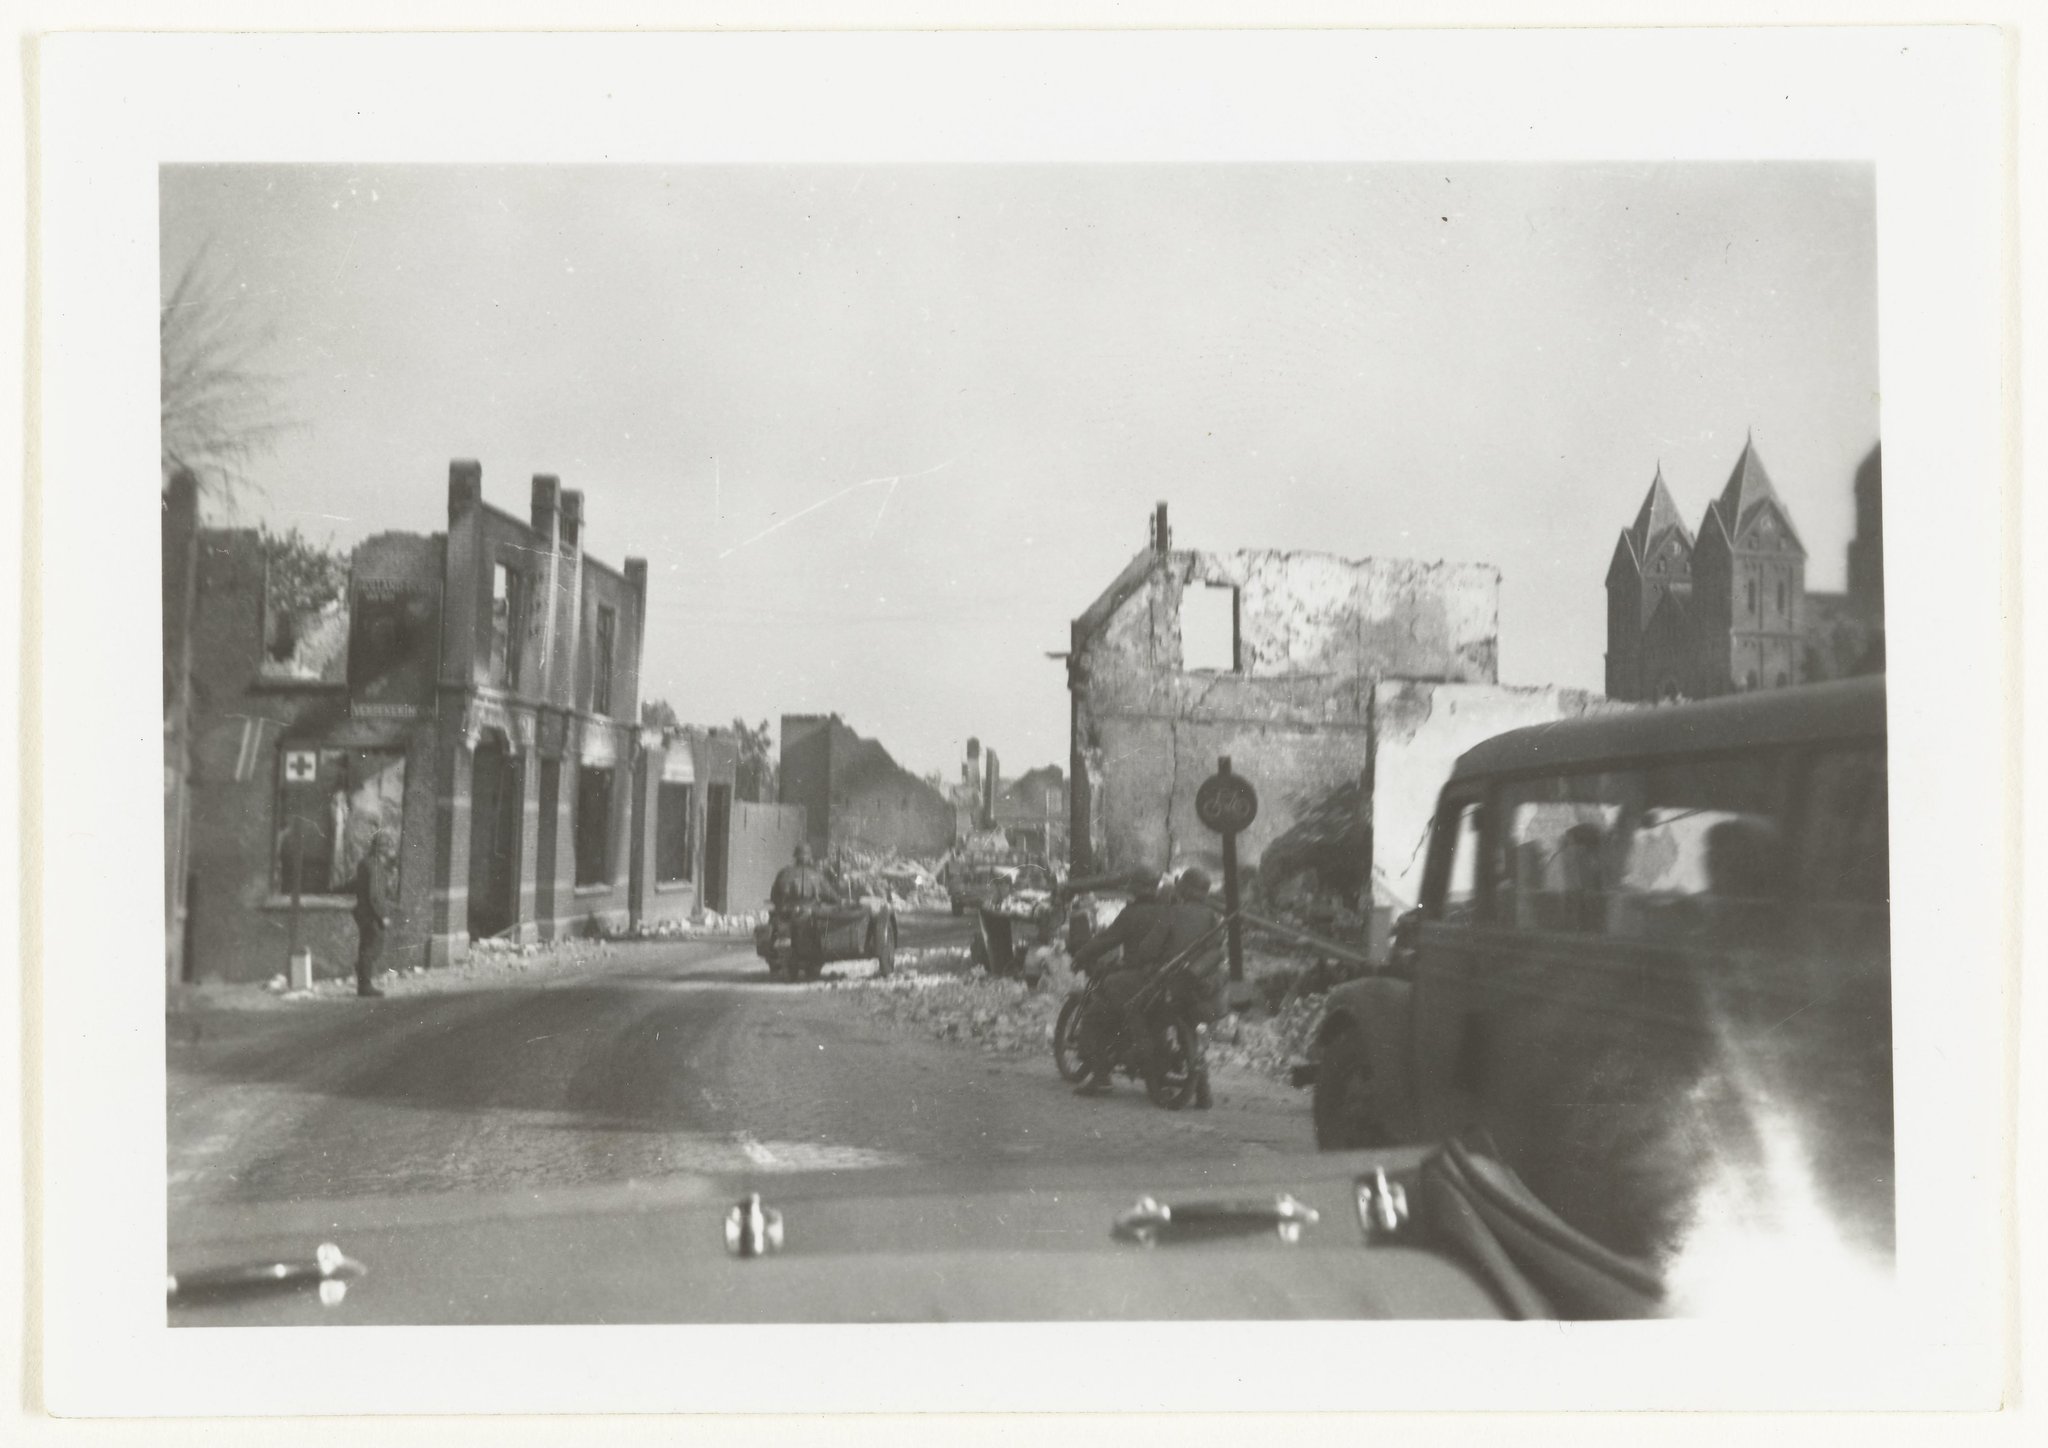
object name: photograph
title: Wehrmacht soldaten in gebombardeerde stad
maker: Anonymous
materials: photographic support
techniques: gelatin silver print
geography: netherlands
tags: devastated, ruined place or city (~ warfare), netherlands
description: Duitse soldaten op motorfietsen rijden door een gebombardeerde stad. Rechts een auto. De foto is genomen vanuit een auto waarvan nog een stuk van de achterkant te zien is.